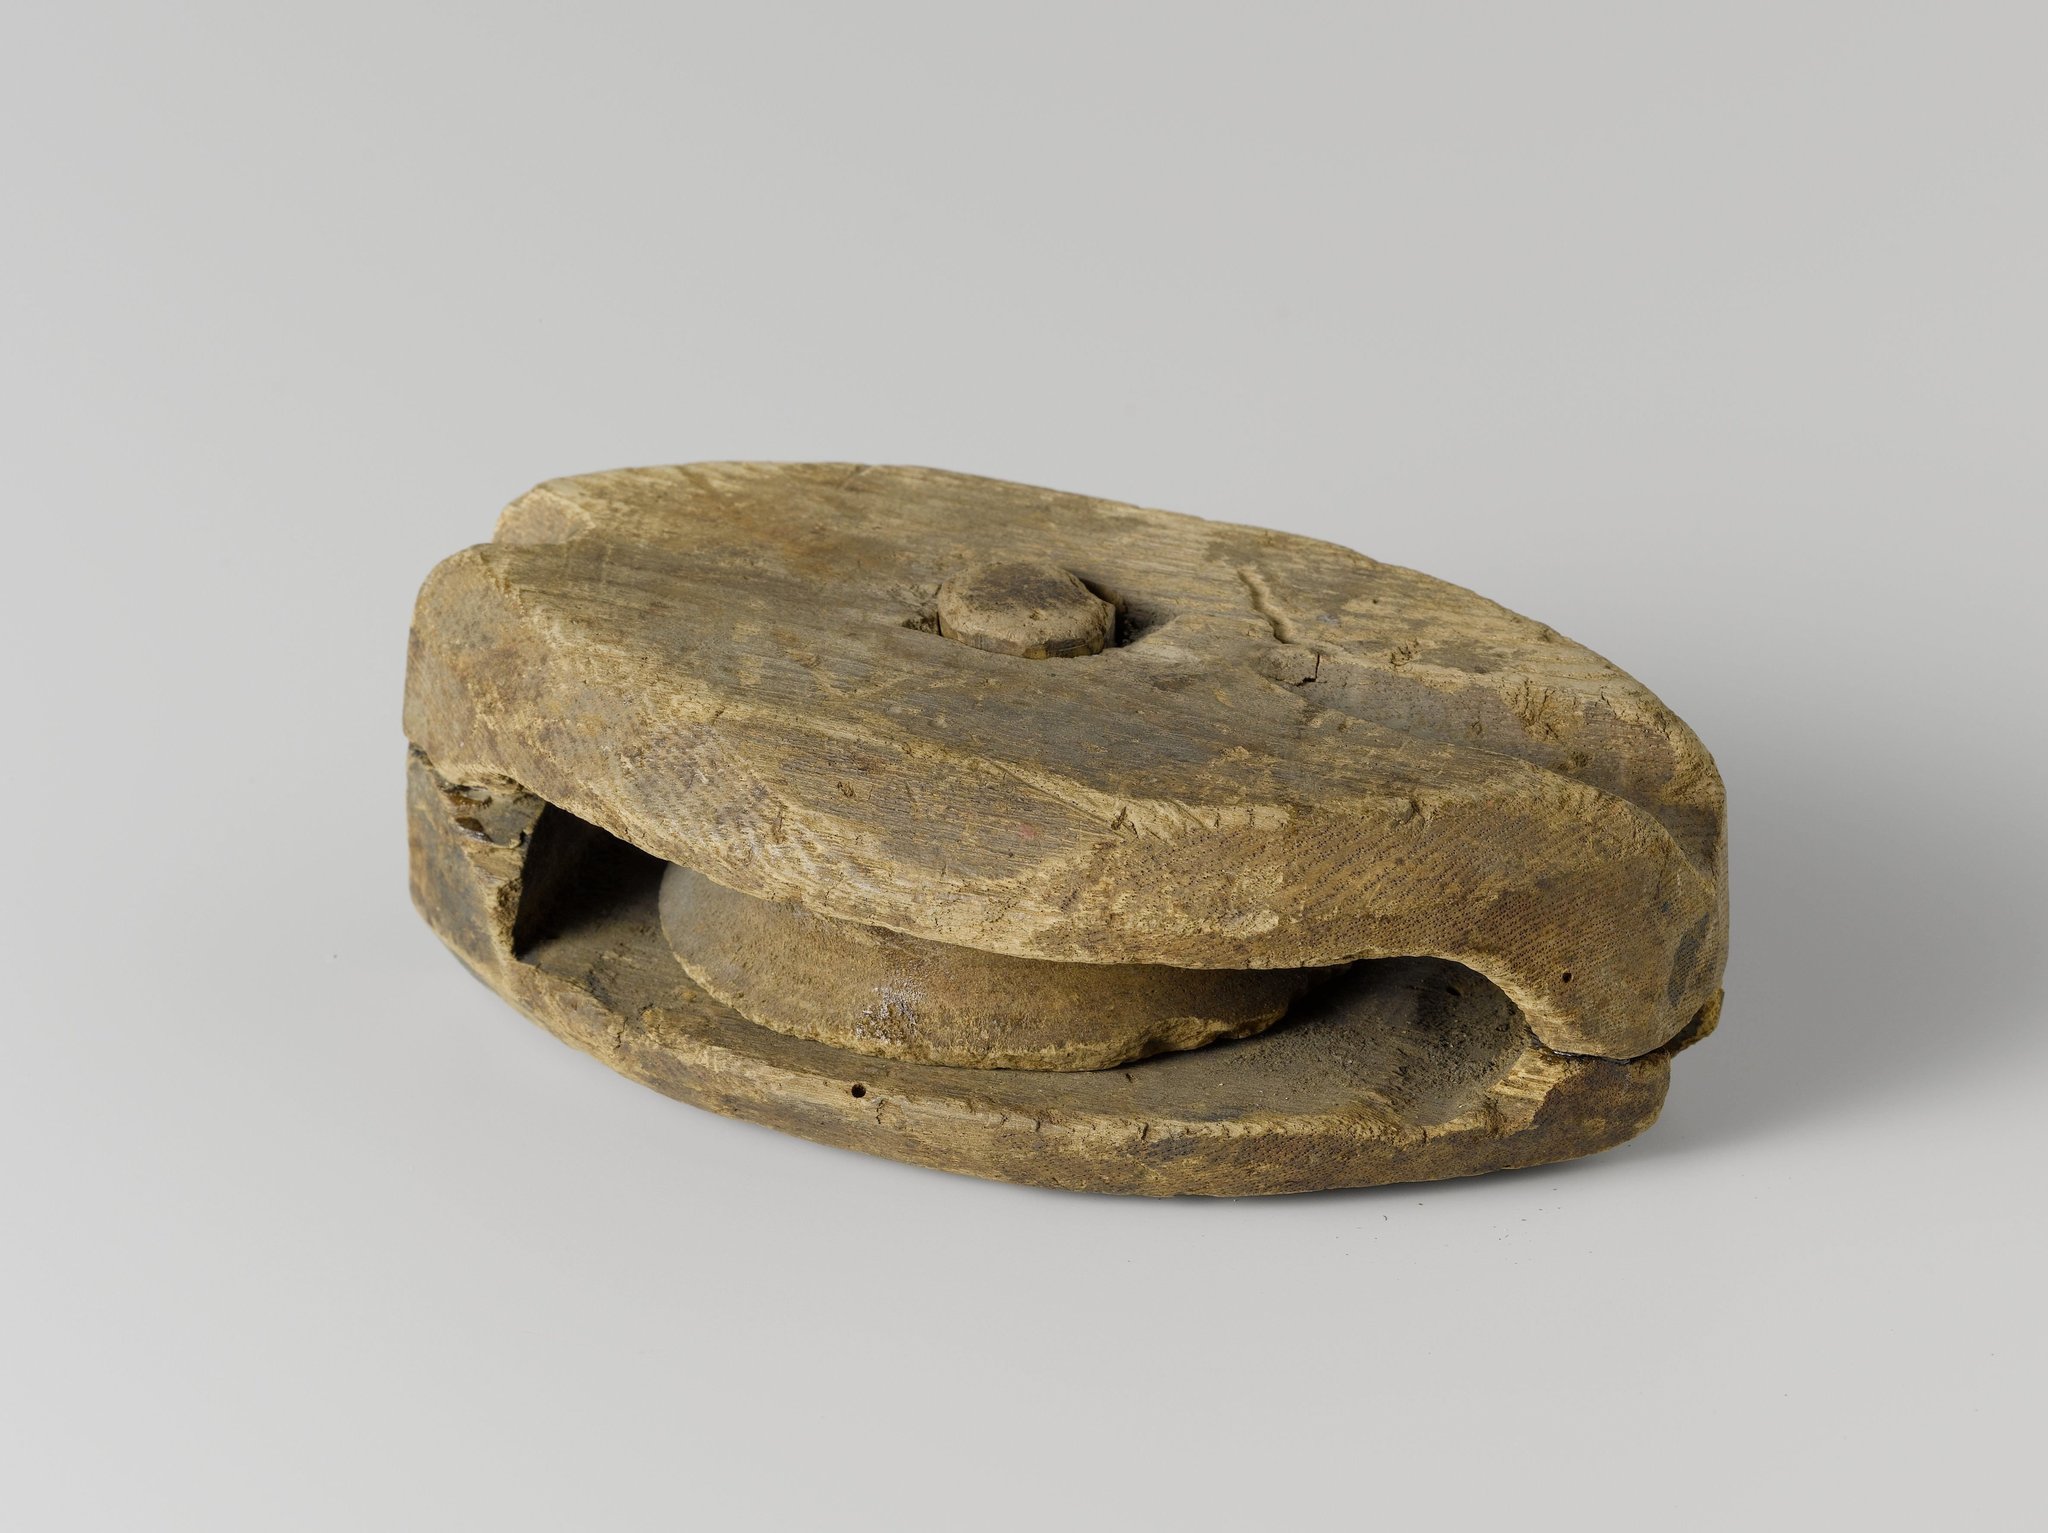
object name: eenschijfsblok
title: Ship’s essentials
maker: Anonymous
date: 1590-1596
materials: wood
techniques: cutting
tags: willem barendsz., amsterdam, jacob van heemskerck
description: Pulleys, boathooks and rope, all these items were recovered on Nova Zembla. The rope in particular is still surprisingly intact. A piece of the hull of Barentsz’ ship has also been preserved and is now kept in St Petersburg.